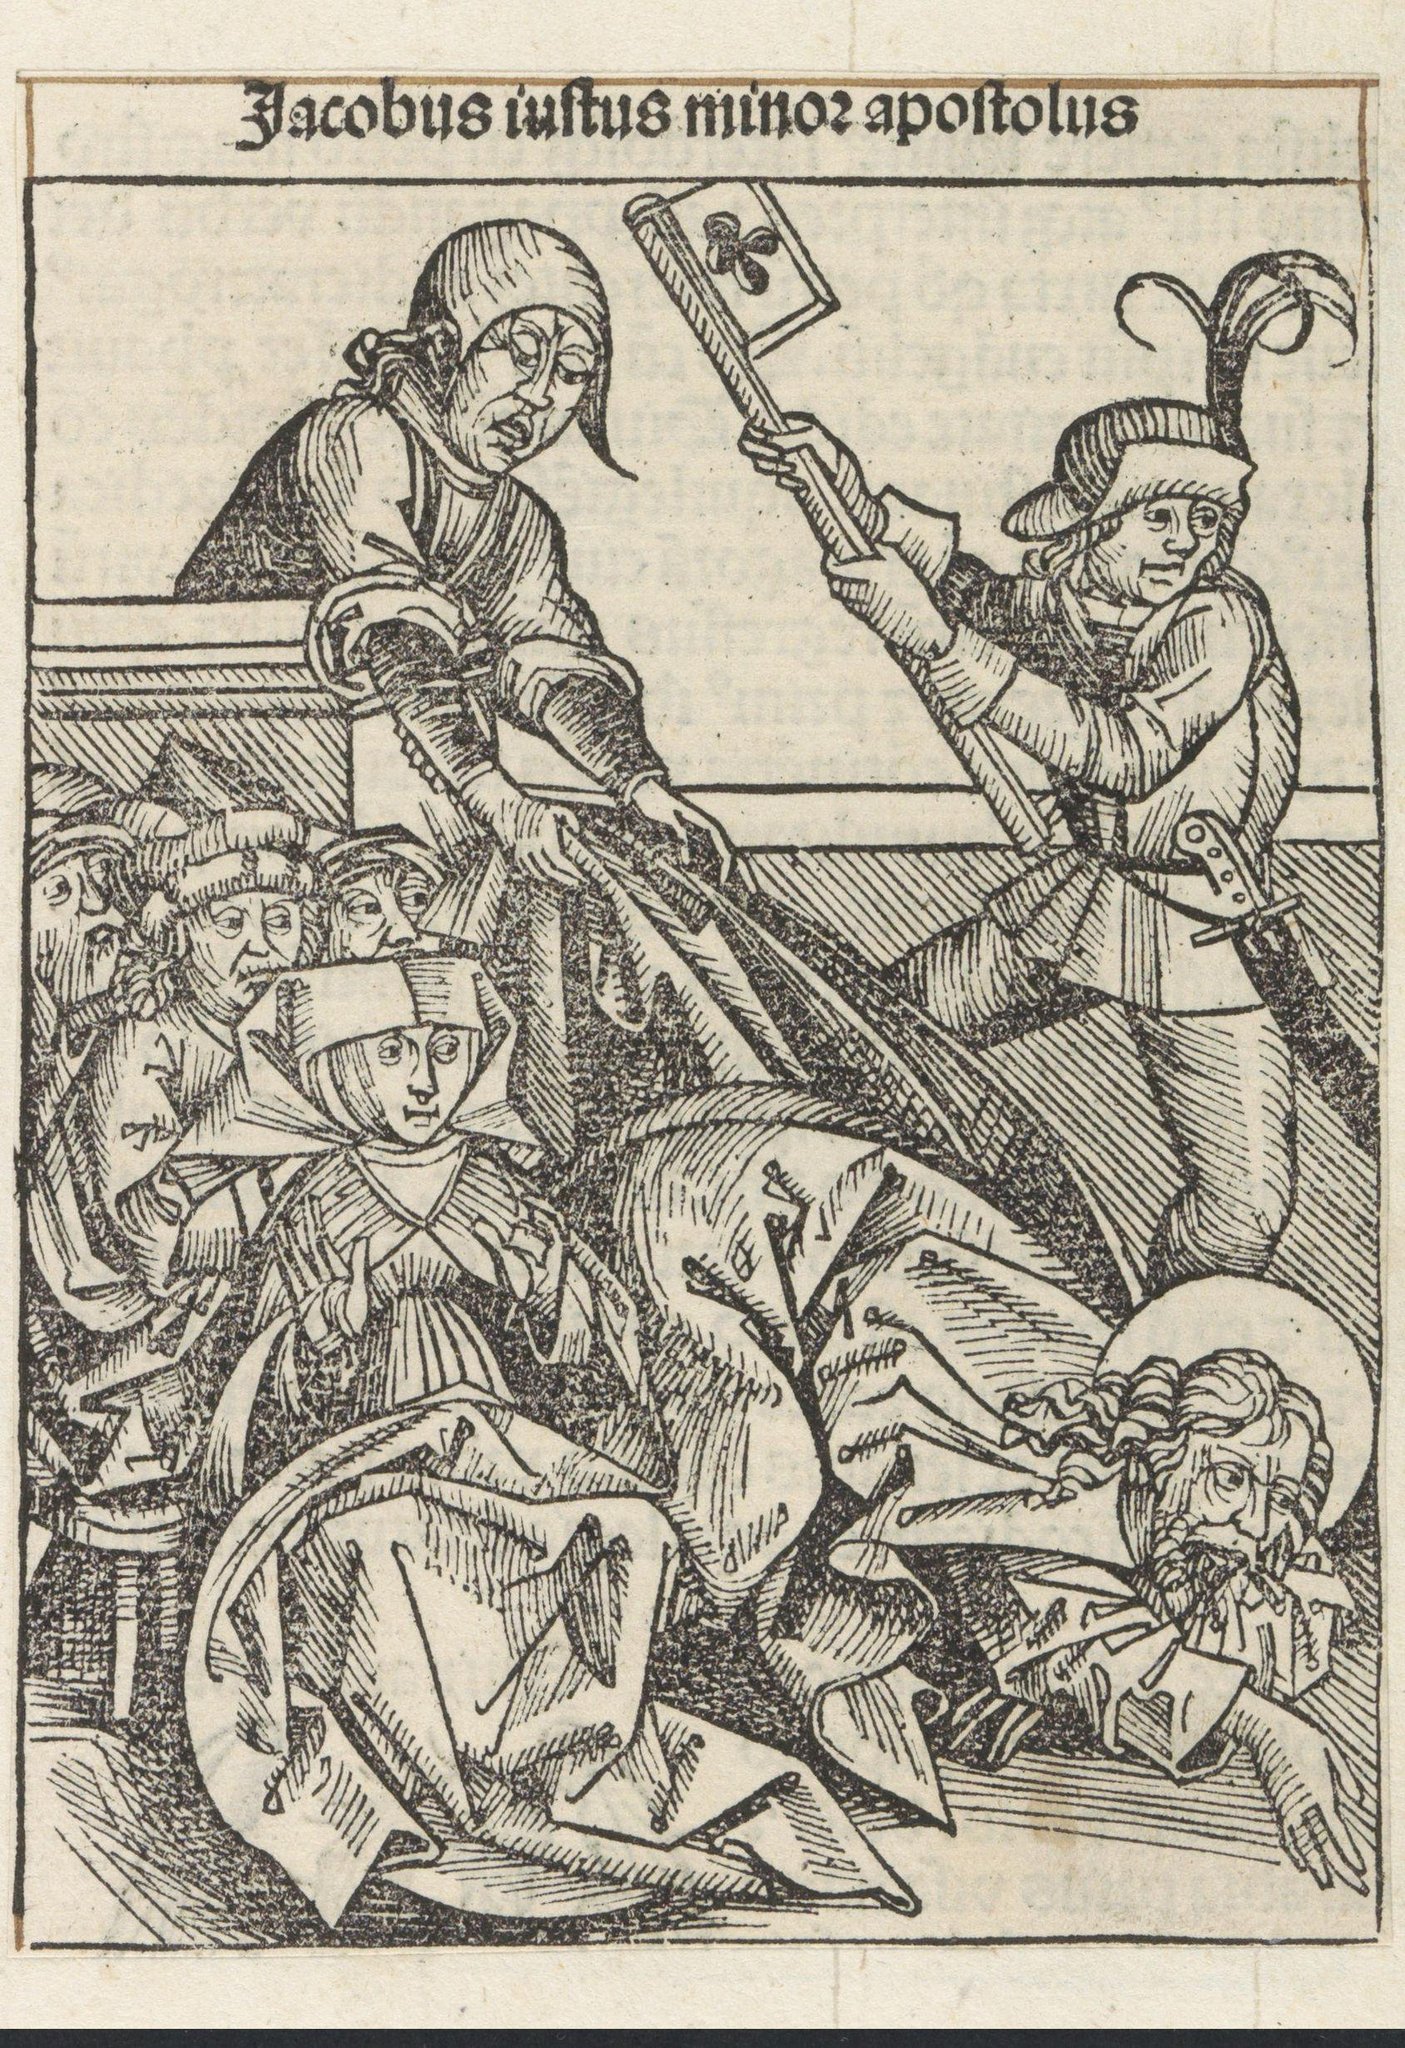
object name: album leaf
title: Jacobus justus minor apostolus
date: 1493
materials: paper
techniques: letterpress printing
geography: nuremberg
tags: james thrown from the roof of a temple in jerusalem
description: De houtsnede wordt gebruikt als boekillustratie in de Liber Chronicarum (of Neurenbergkroniek) van Hartmann Schedel, verschenen in het Latijn en Duits in 1493. Zie de Latijnse uitgave, folio 104v.